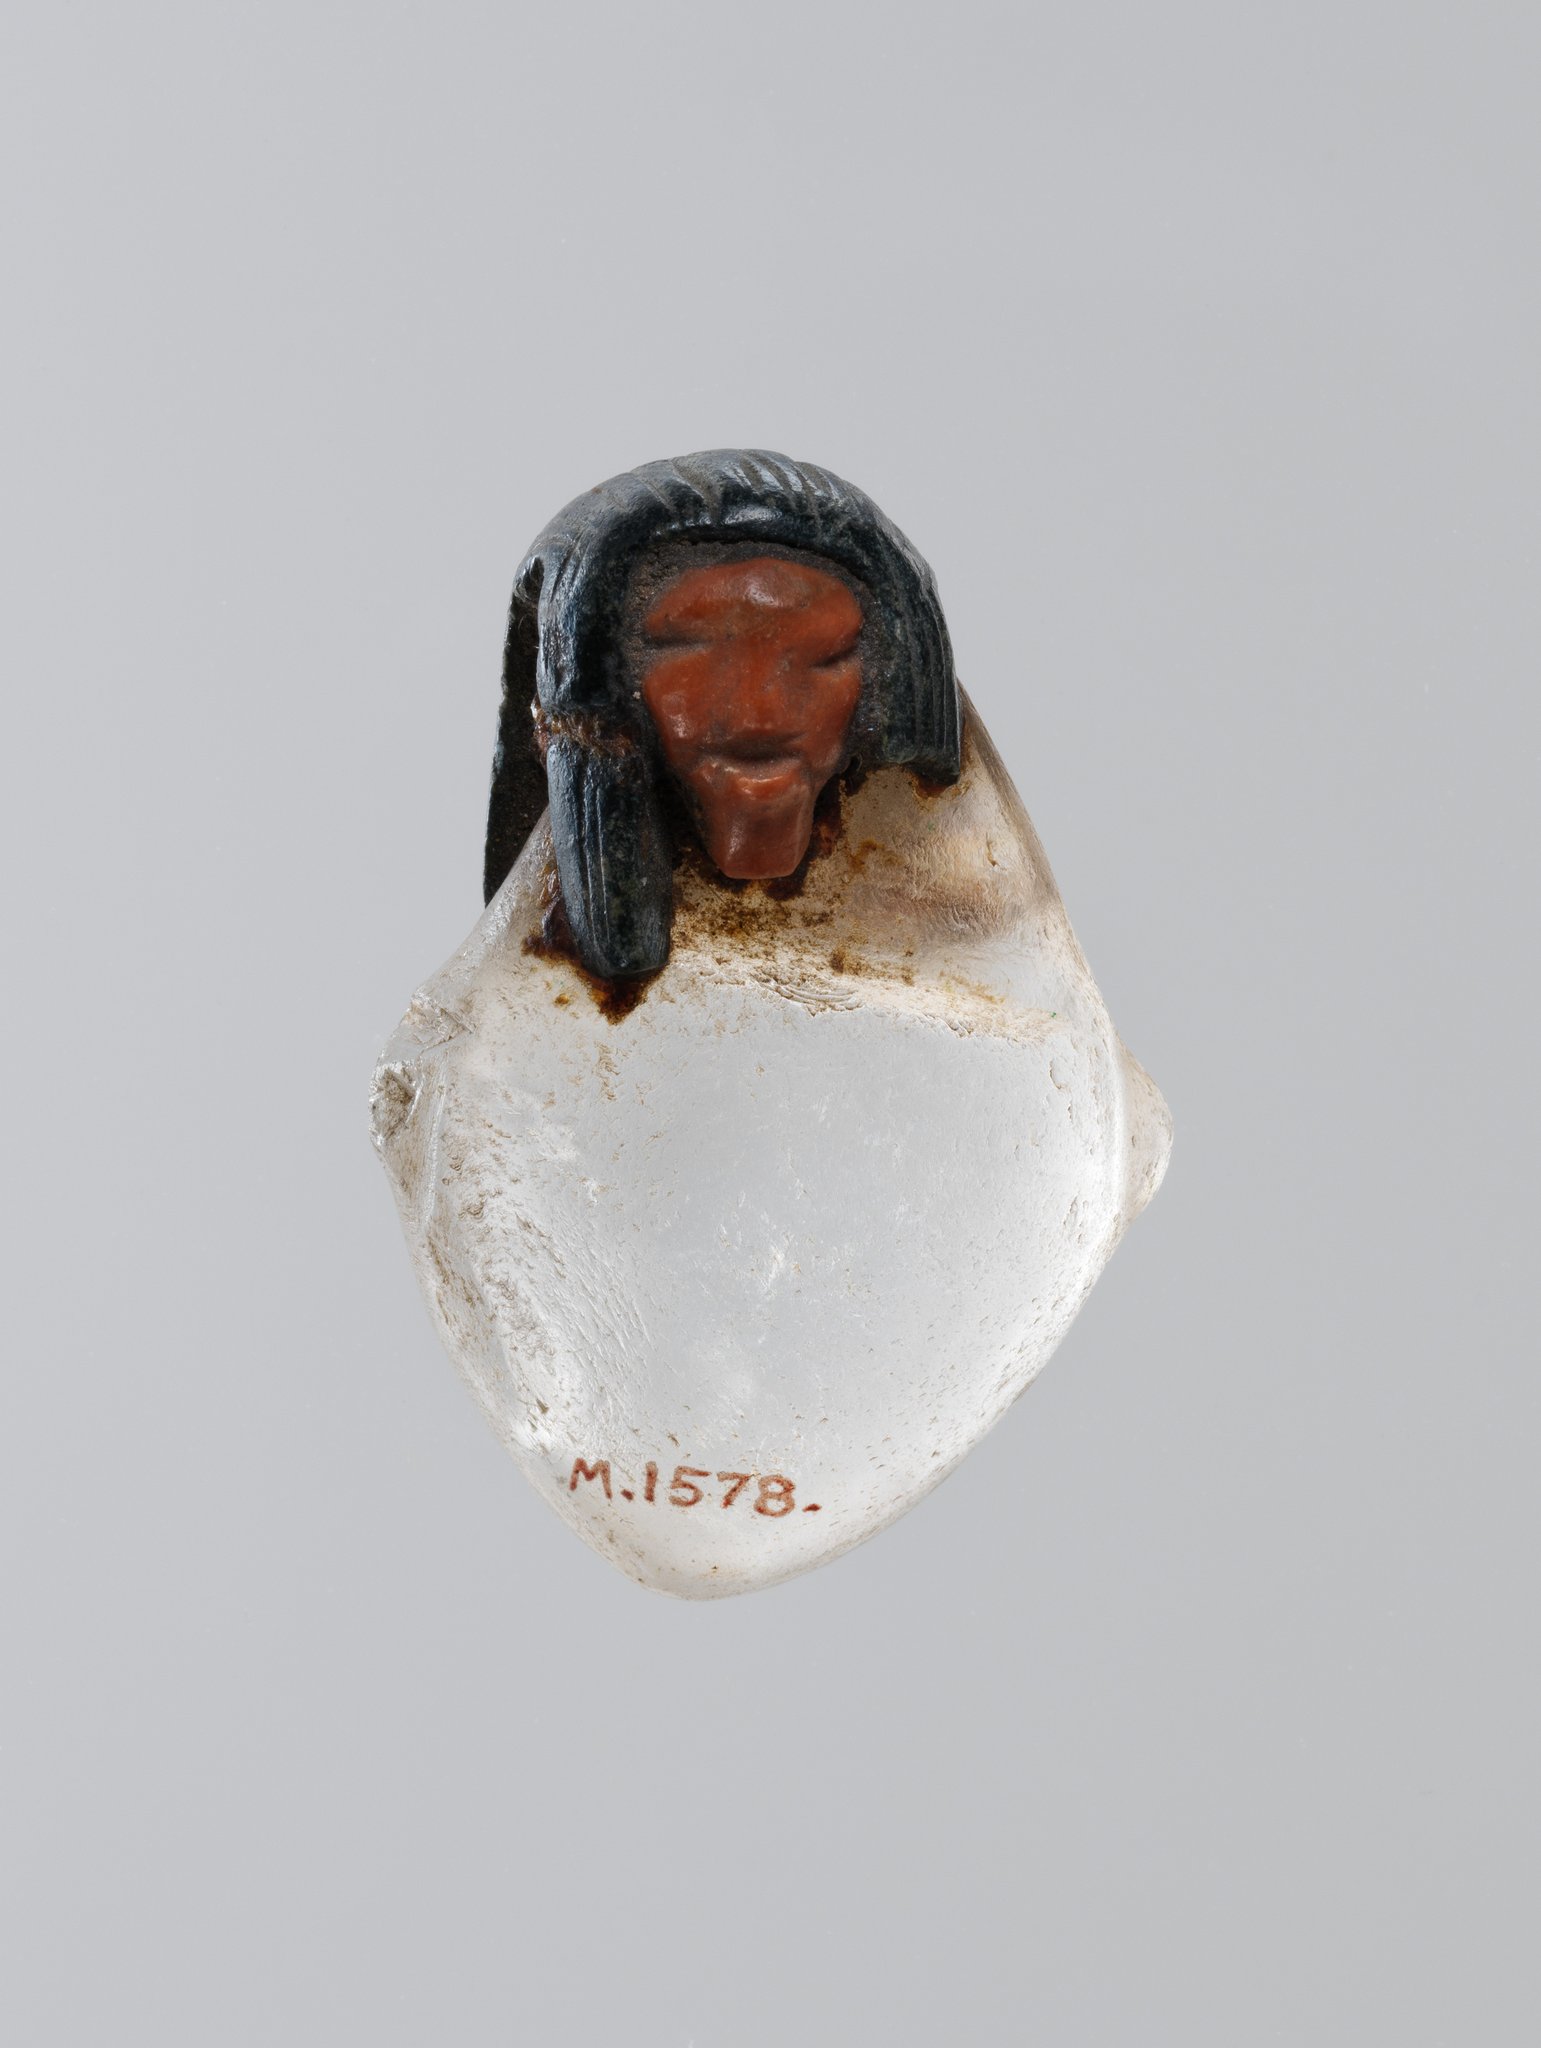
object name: amulet, heart with human head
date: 1295-1070 BCE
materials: gemstone, quartz, stone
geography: egypt